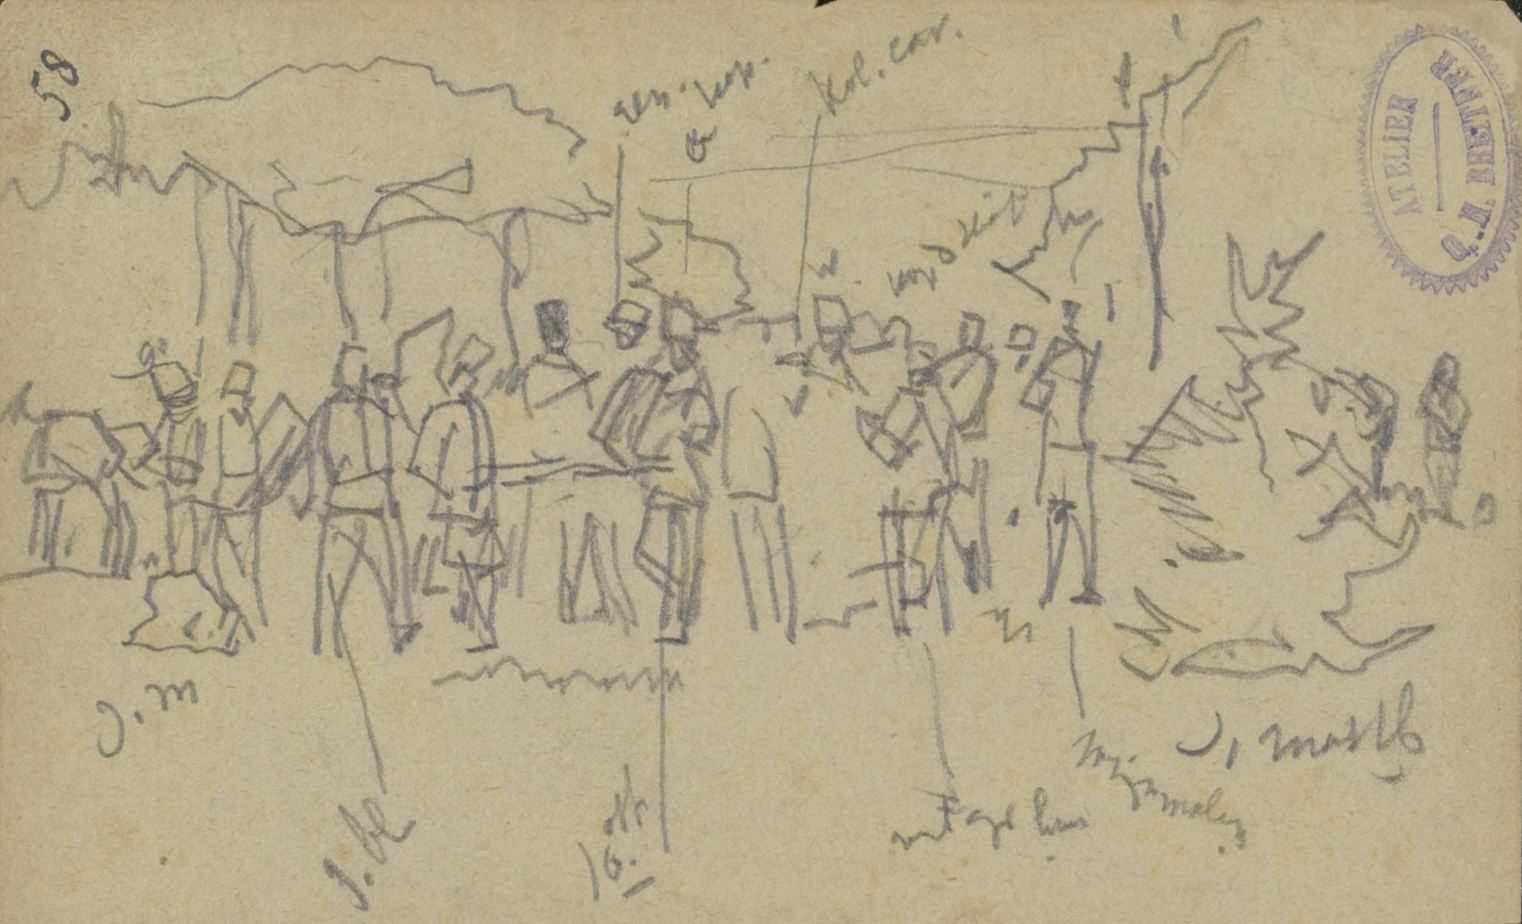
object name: drawing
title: Landschap met paarden en soldaten, mogelijk huzaren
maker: george hendrik breitner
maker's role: draughtsman, painter, print maker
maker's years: 1857-1923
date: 1887-1891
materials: paper, pencil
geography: gelderland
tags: private soldier (+ land forces), horse, landscapes in the temperate zone (+ landscape with figures, staffage)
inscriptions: :, workshop stamp: Lugt 291d